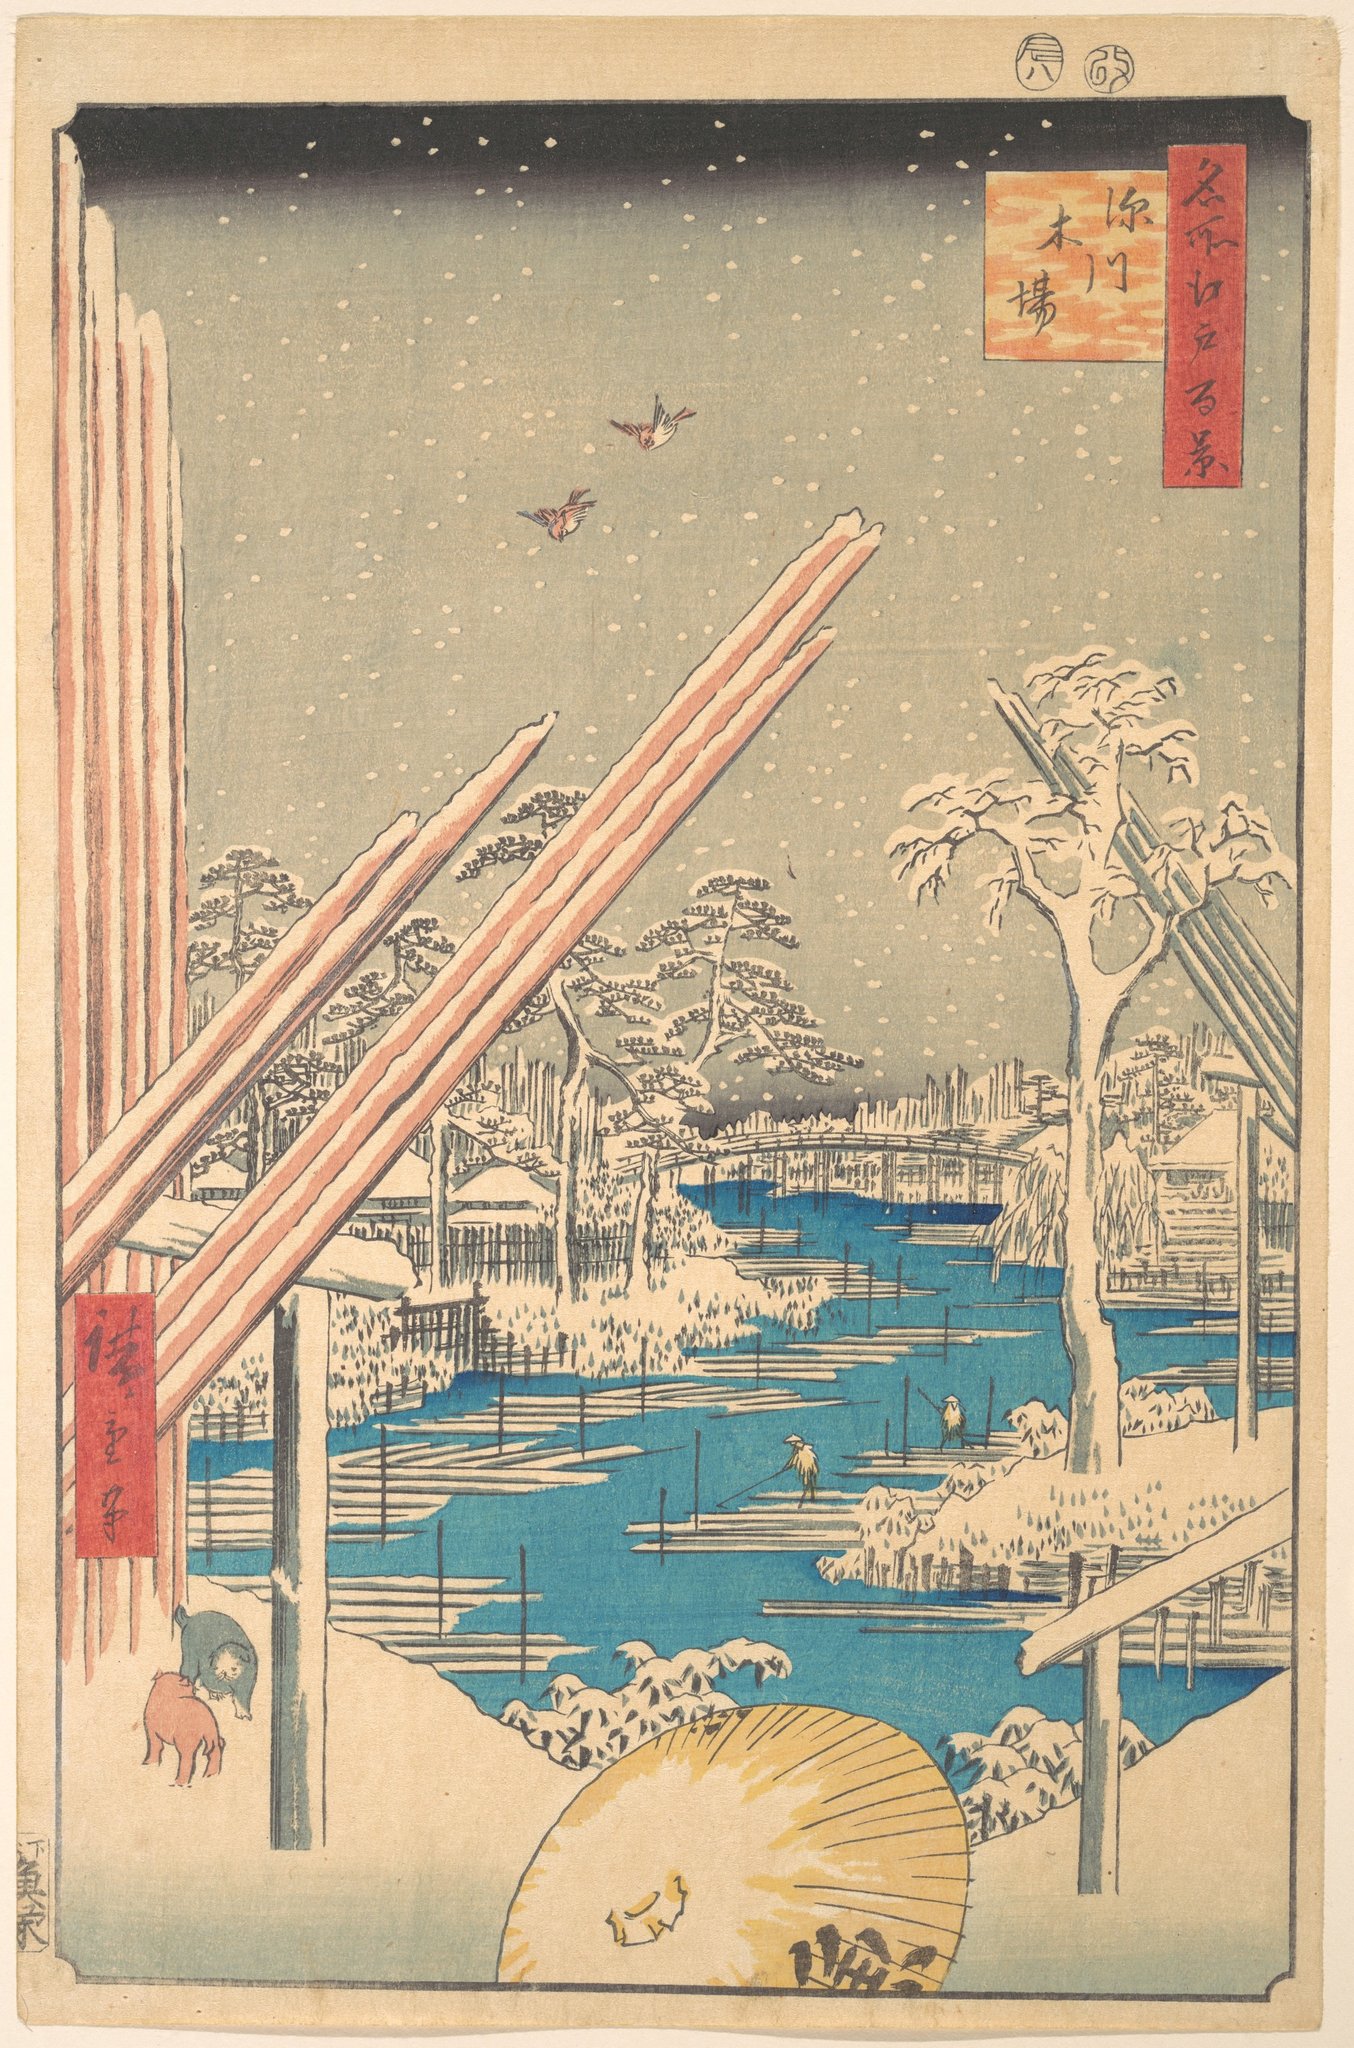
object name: print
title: The Lumber Yard at Fukagawa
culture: japanese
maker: utagawa hiroshige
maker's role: artist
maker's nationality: japanese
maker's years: 1797-1858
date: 1856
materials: ink, paper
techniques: woodblock print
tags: animals,trees,snow